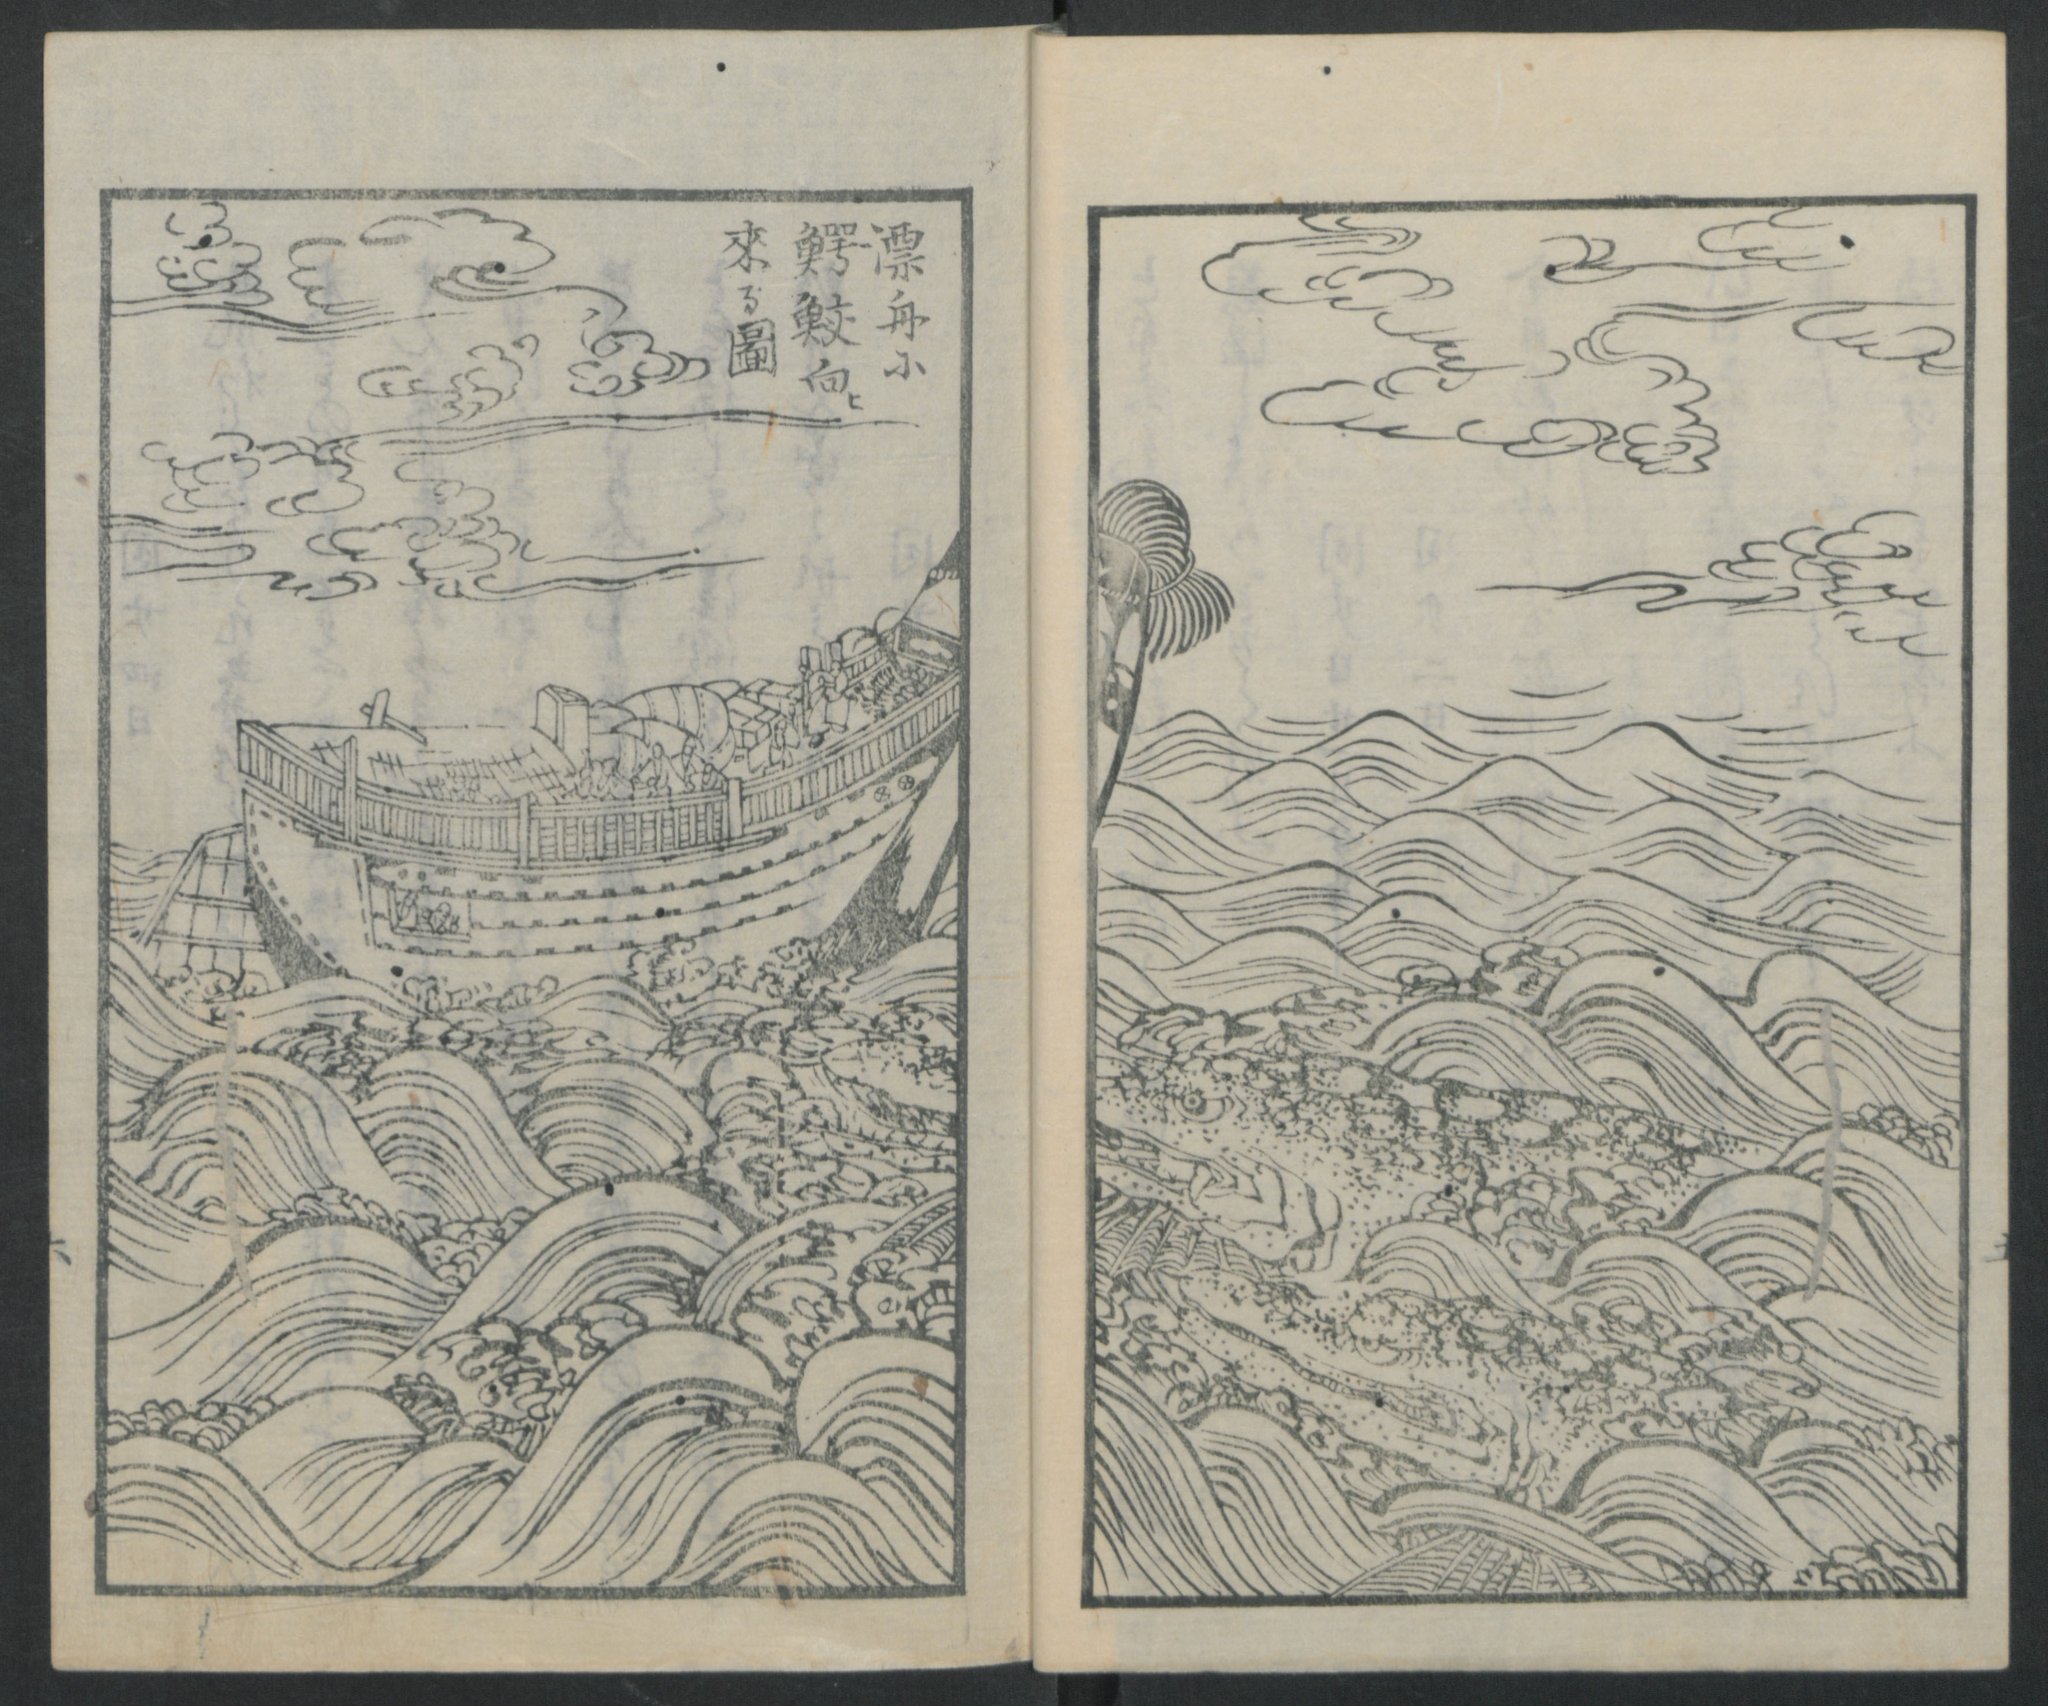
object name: illustrated book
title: Memoirs of a Castaway (Hyōryūki) 流記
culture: japanese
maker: hamada hikozō 浜田彦蔵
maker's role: artist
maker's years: 1837-1897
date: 1863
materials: ink, paper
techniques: woodblock print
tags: waves,boats